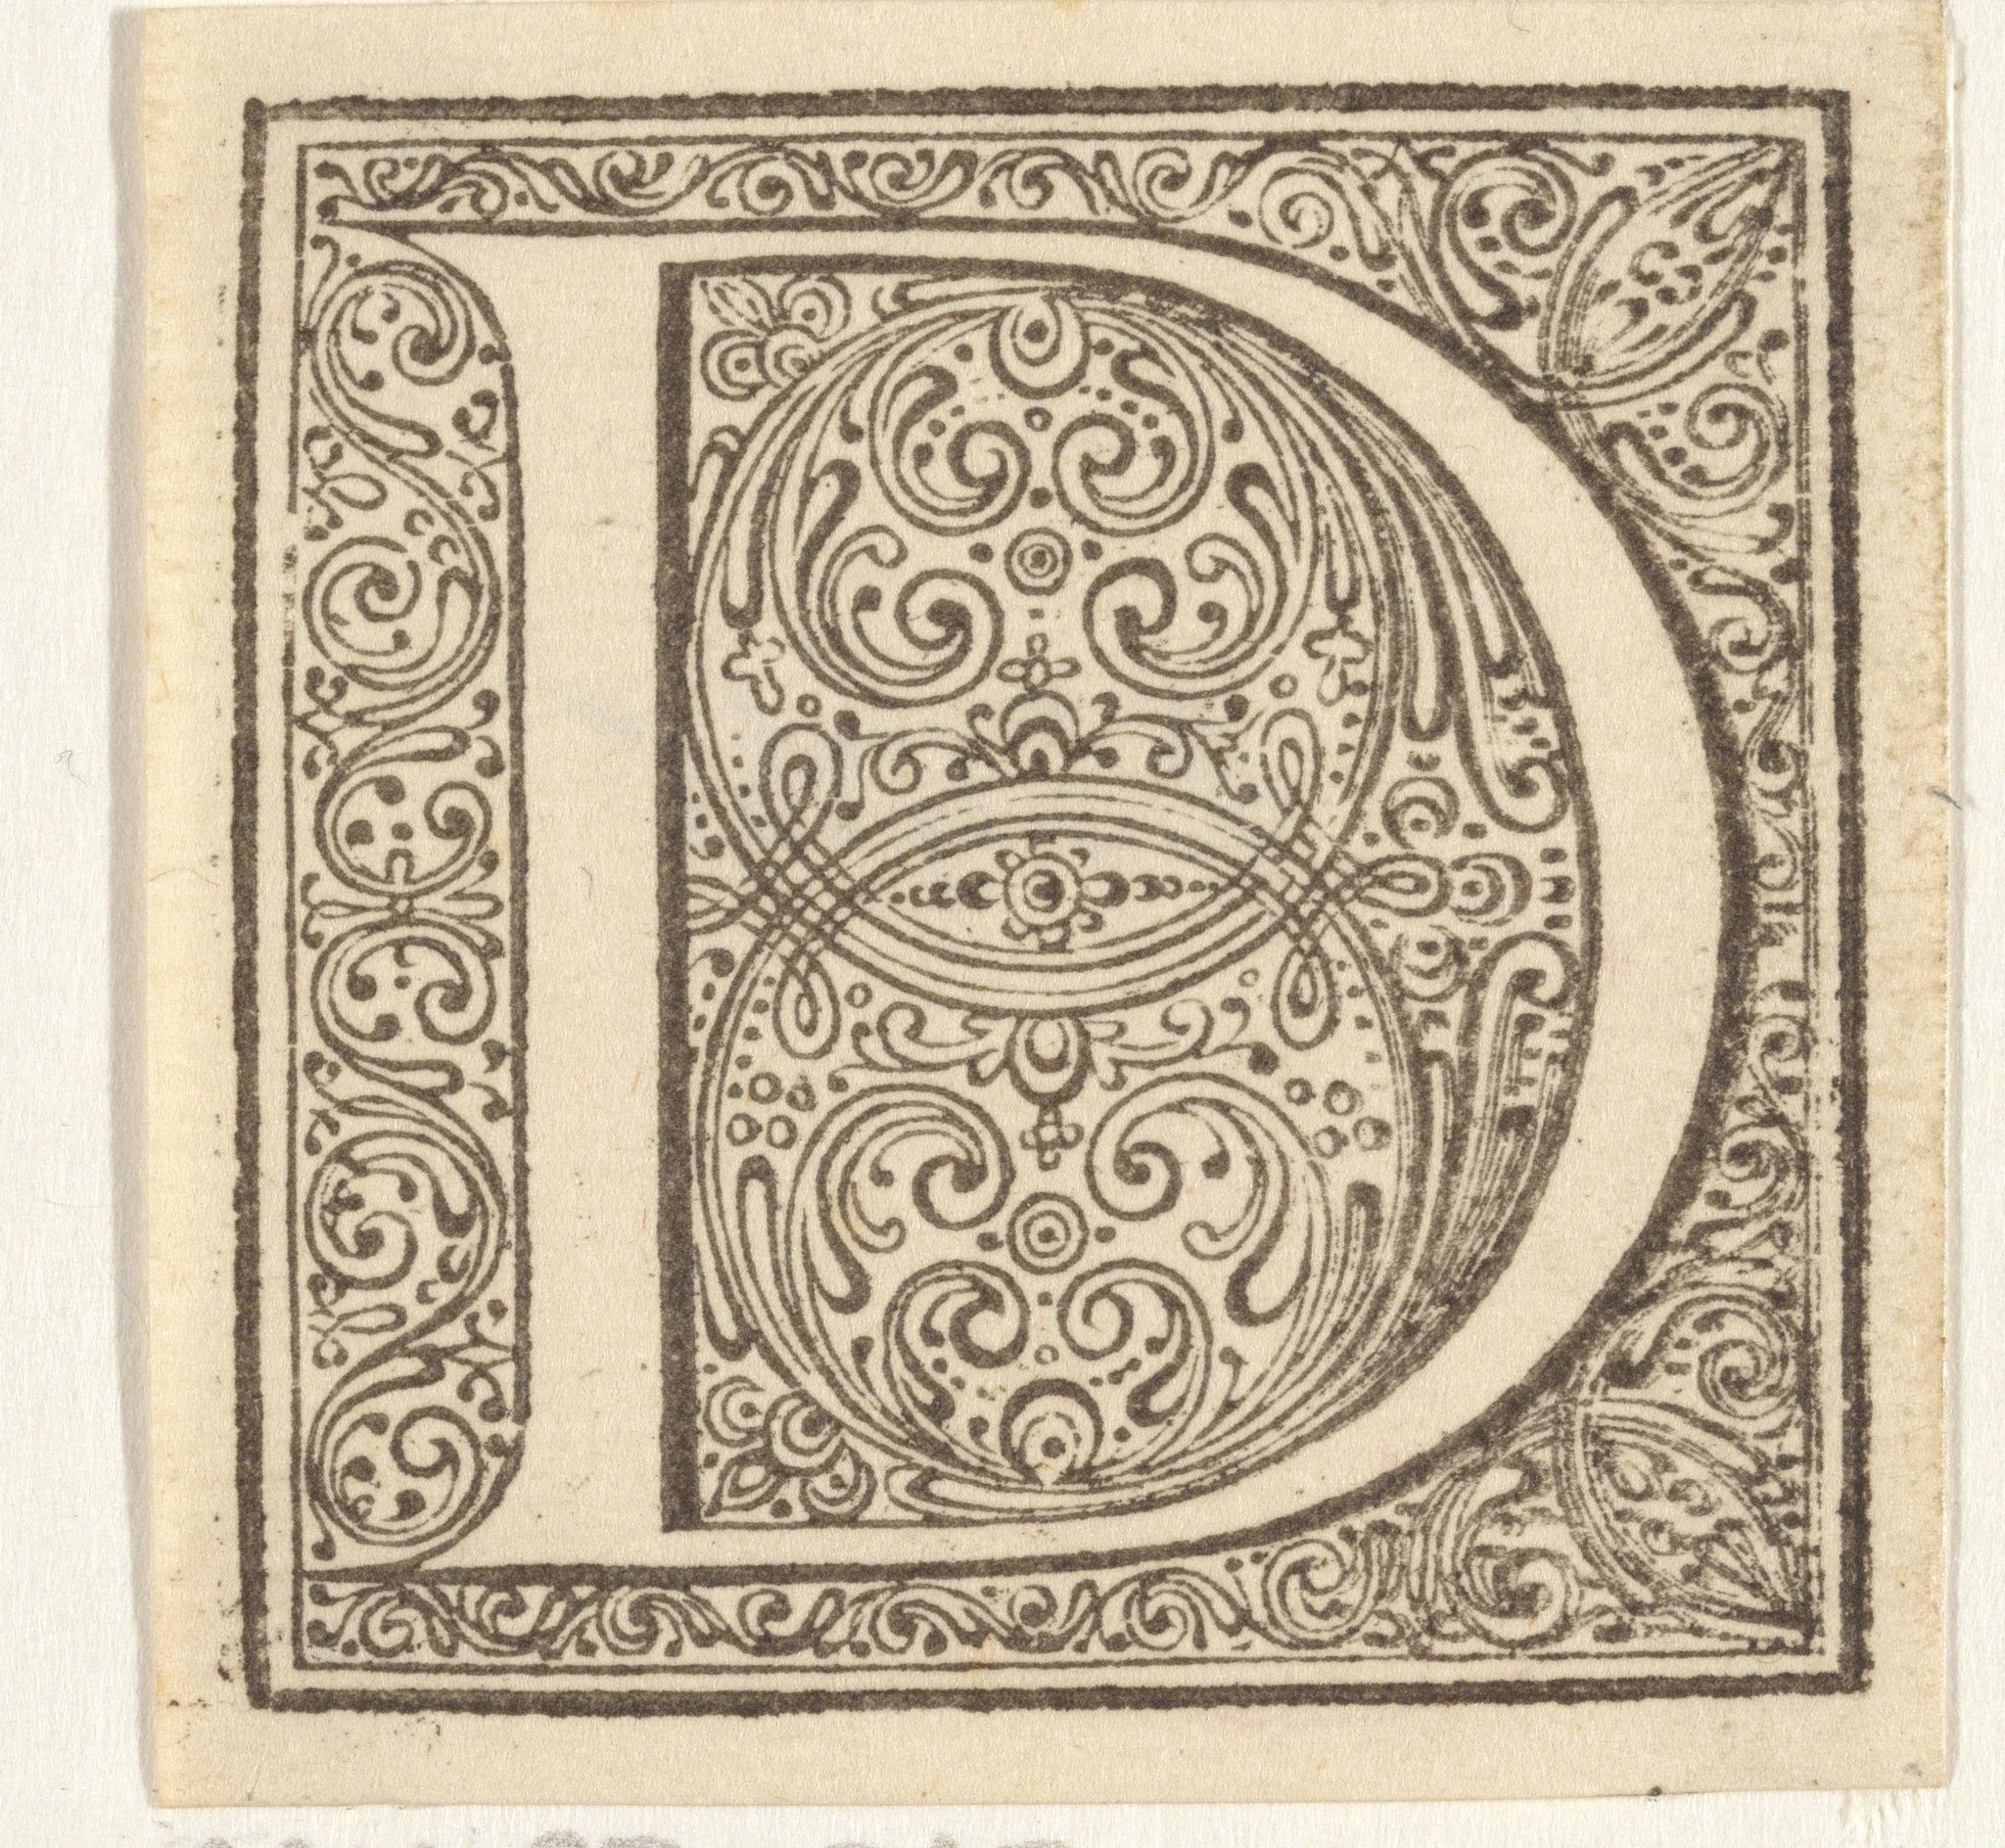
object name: print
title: Letter D in een geornamenteerde omlijsting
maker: Anonymous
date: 1600-1699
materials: paper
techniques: woodcut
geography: netherlands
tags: fancy letters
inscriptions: collector's mark: Lugt 240